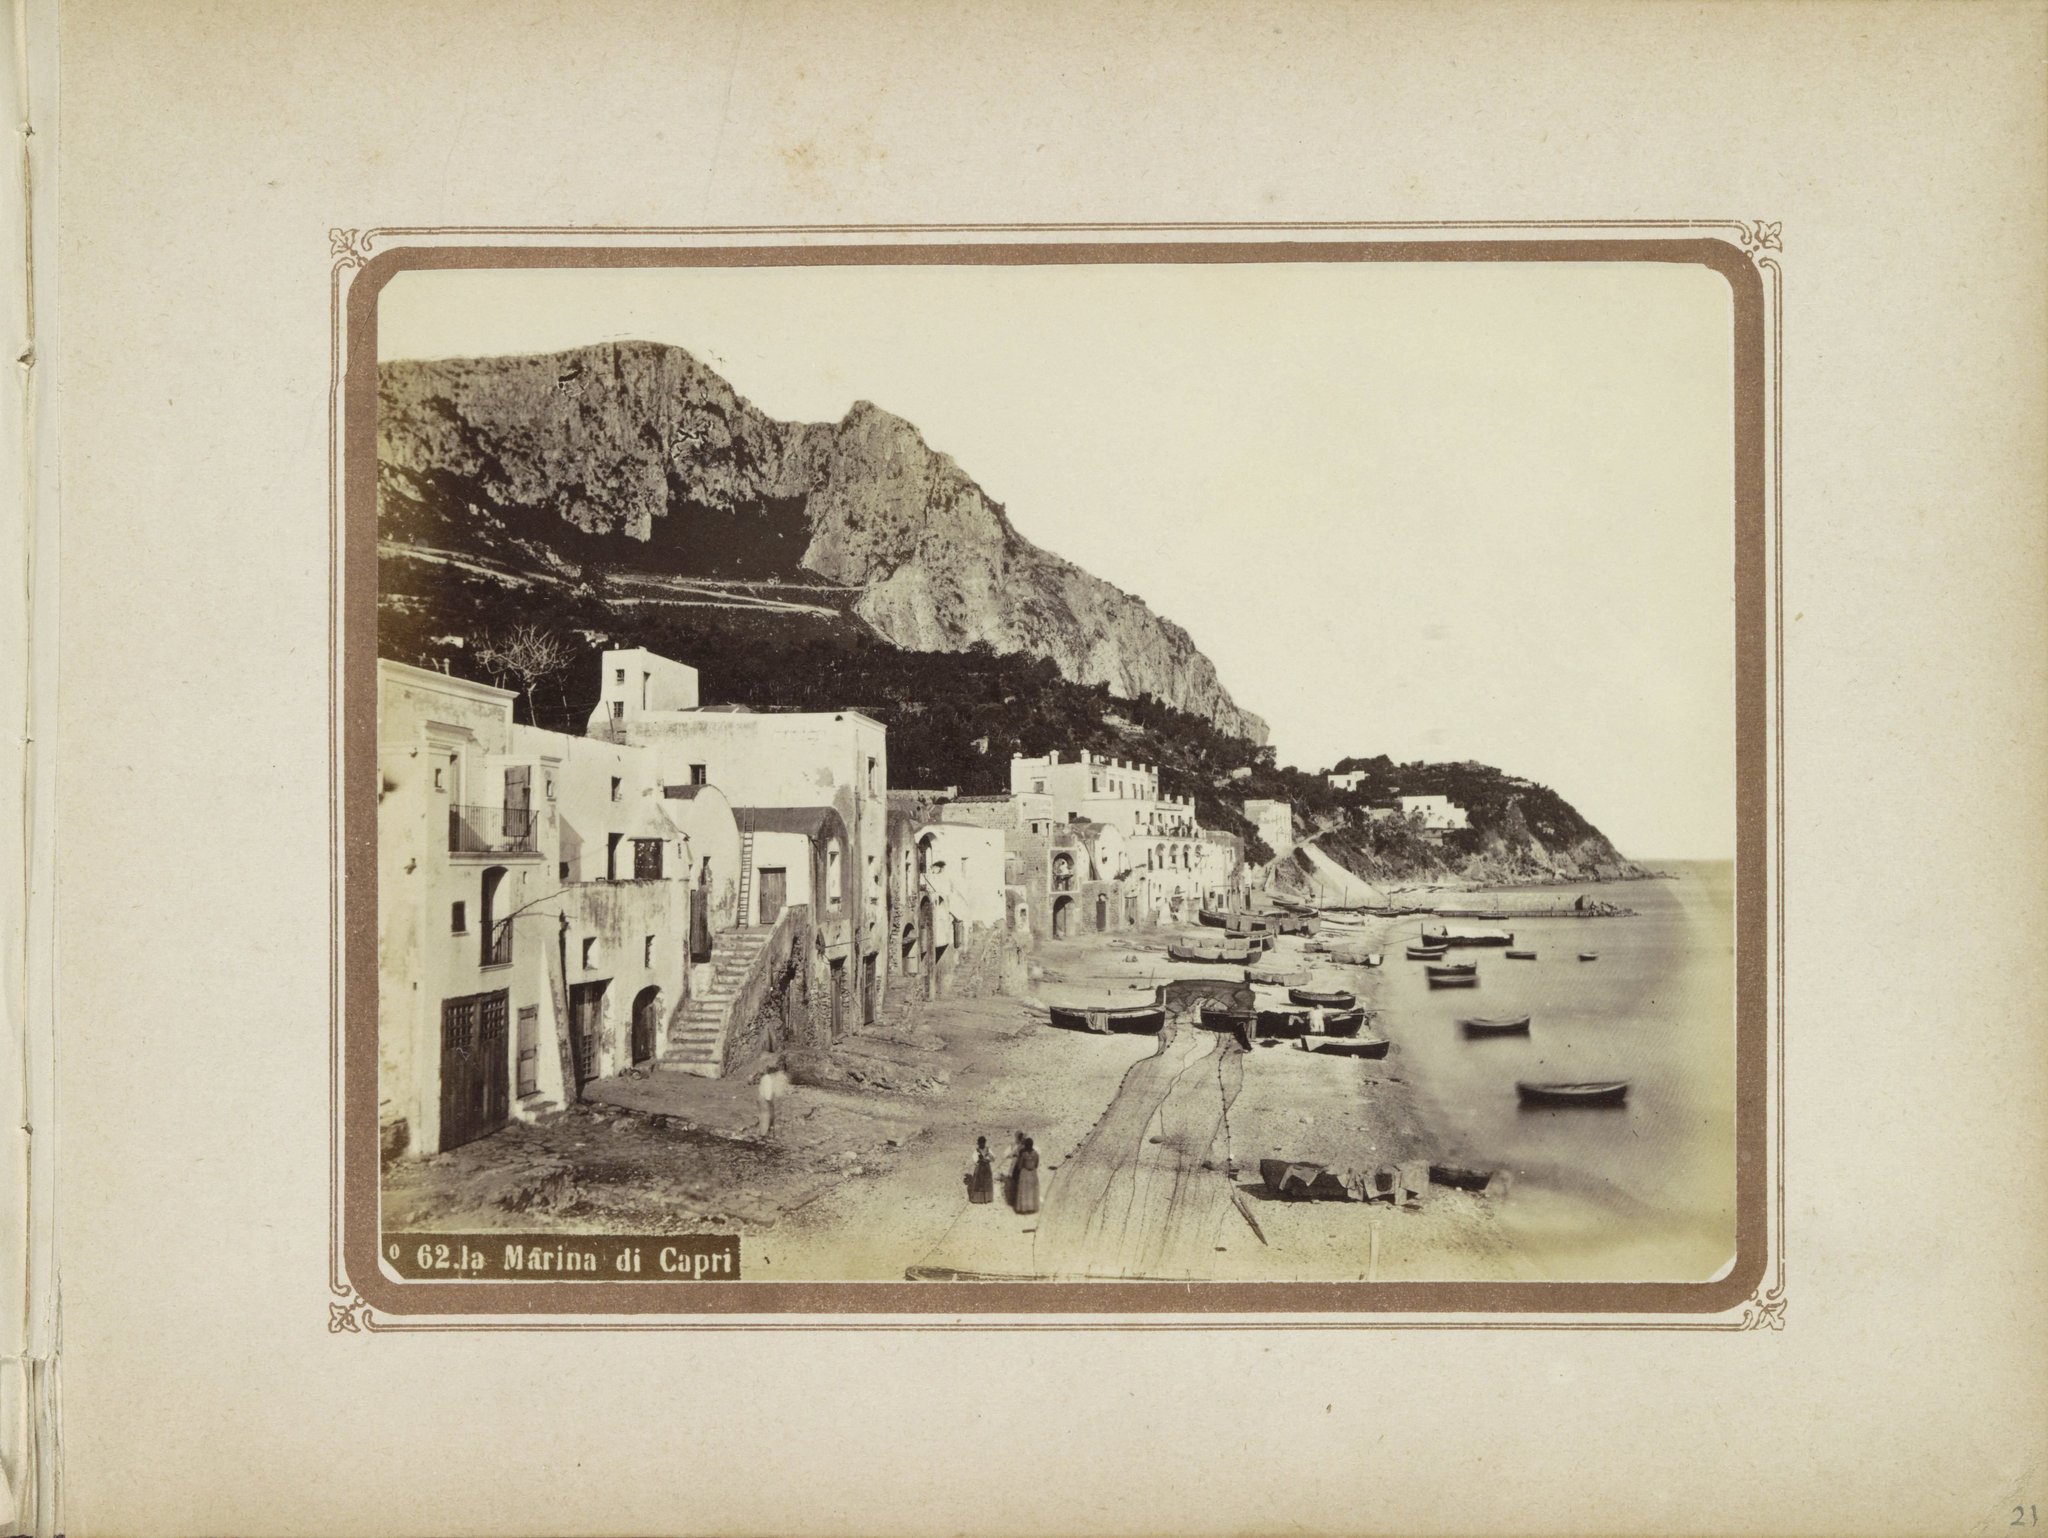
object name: album leaf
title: Marina di Capri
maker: roberto rive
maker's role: fotograaf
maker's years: 1825-1868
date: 1860-1900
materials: paper, photographic support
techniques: albumen print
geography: capri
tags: harbour (+ view ~ vehicle, ship, etc.), capri, isola di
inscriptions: number: ‘62’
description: Onderdeel van Fotoalbum met bezienswaardigheden in Napels en omgeving door Roberto Rive.